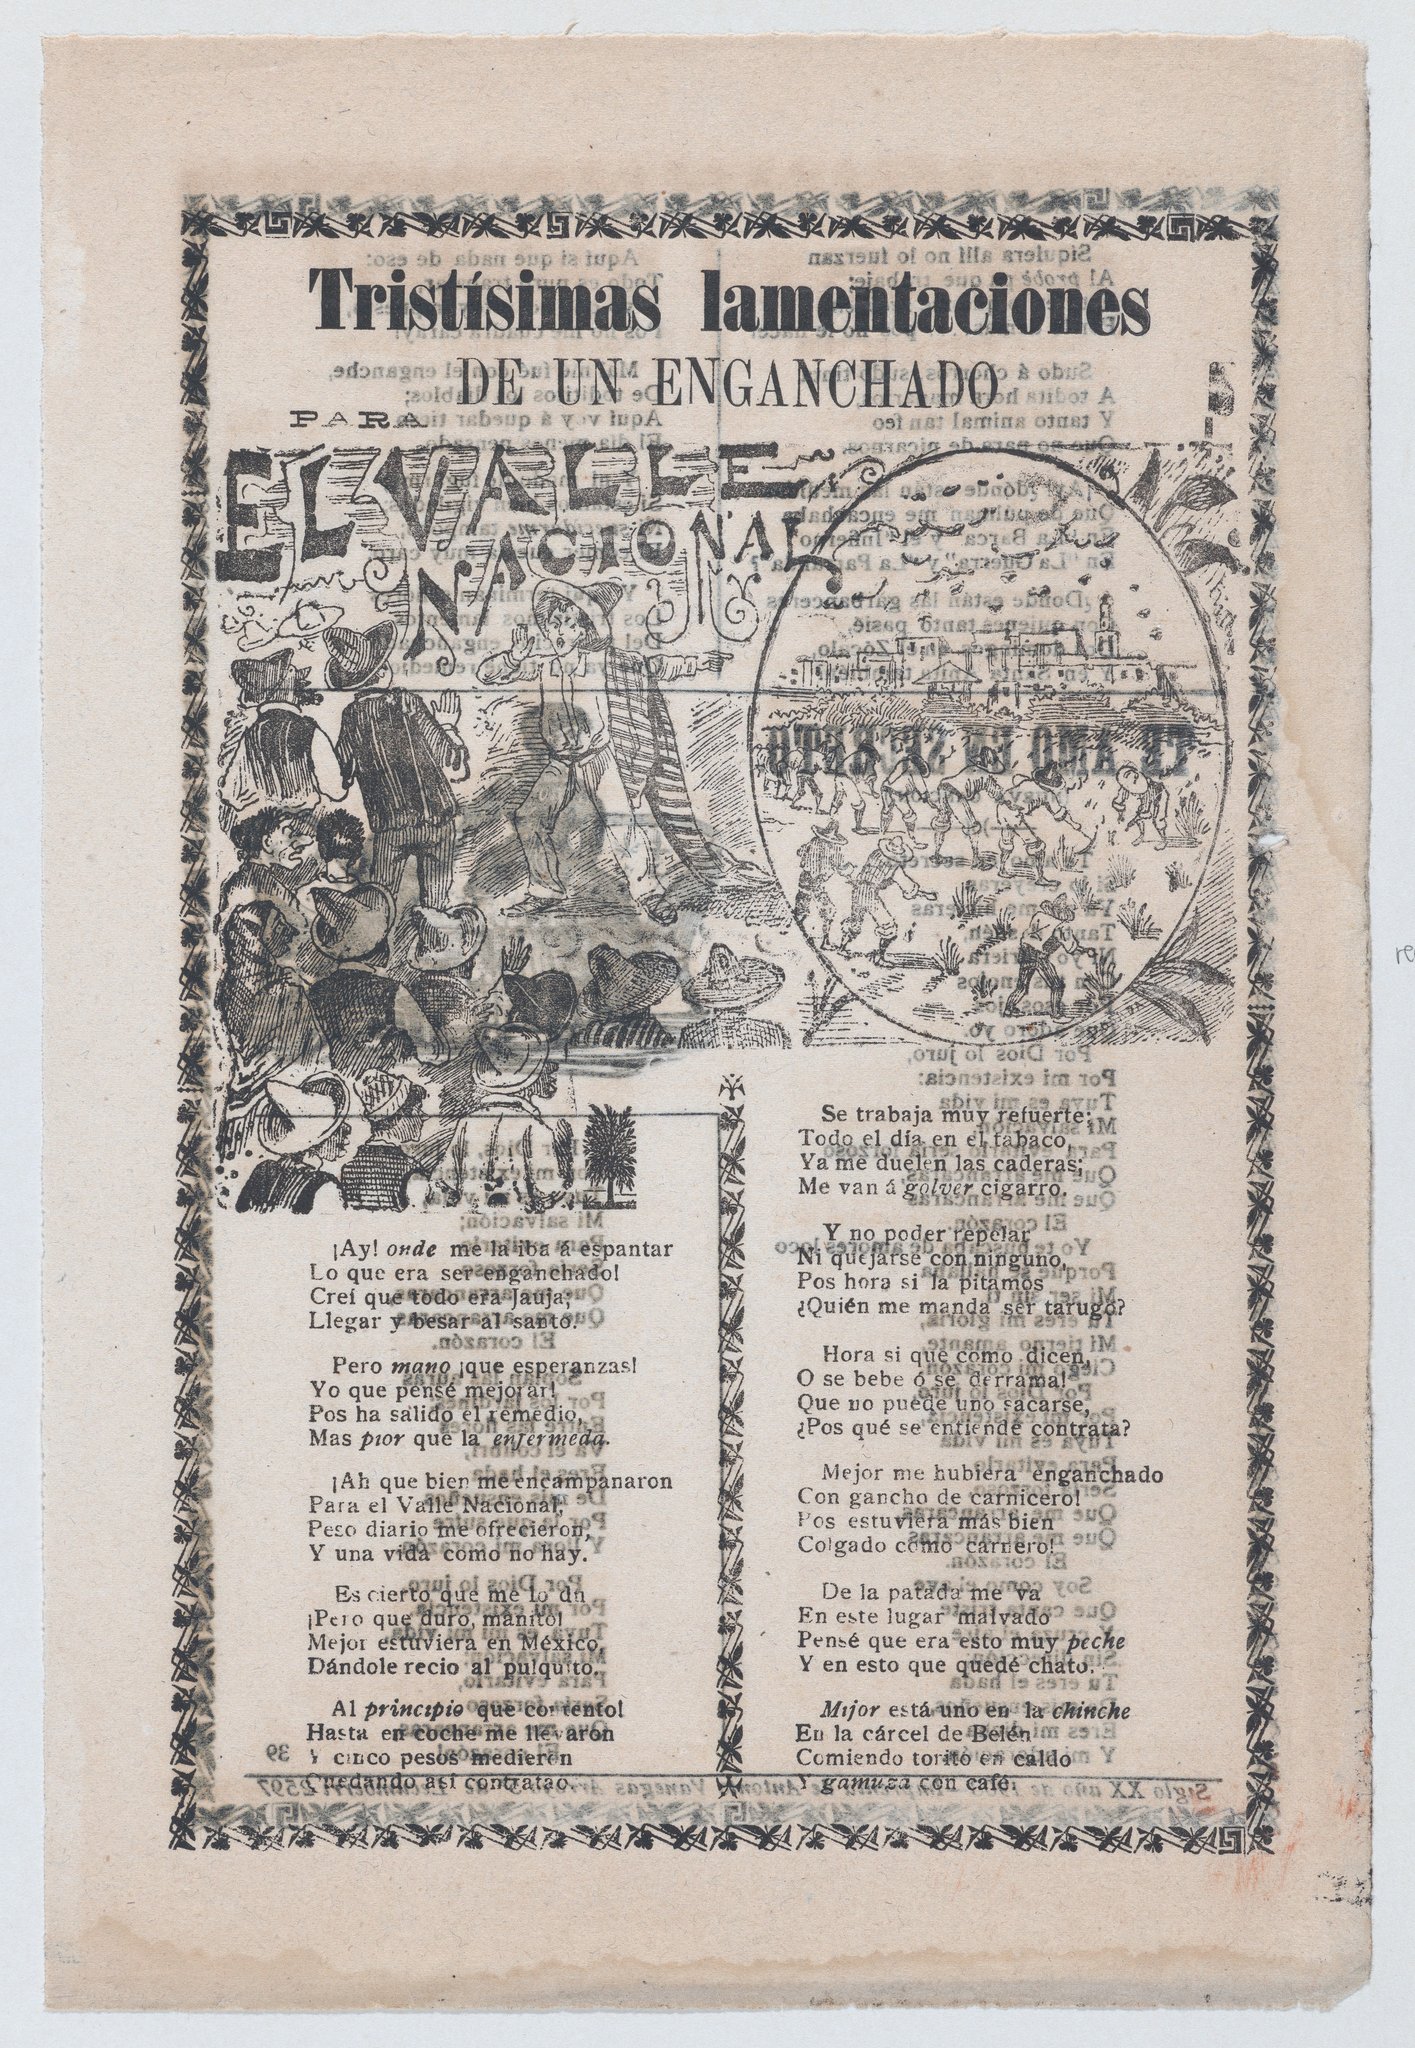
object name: print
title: Broadsheet relating to people being tricked into working in tobacco fields, a man warning a crowd about harsh labor conditions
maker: josé guadalupe posada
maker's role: artist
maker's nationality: mexican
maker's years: 1852-1913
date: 1903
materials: paper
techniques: letterpress, lithography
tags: human figures